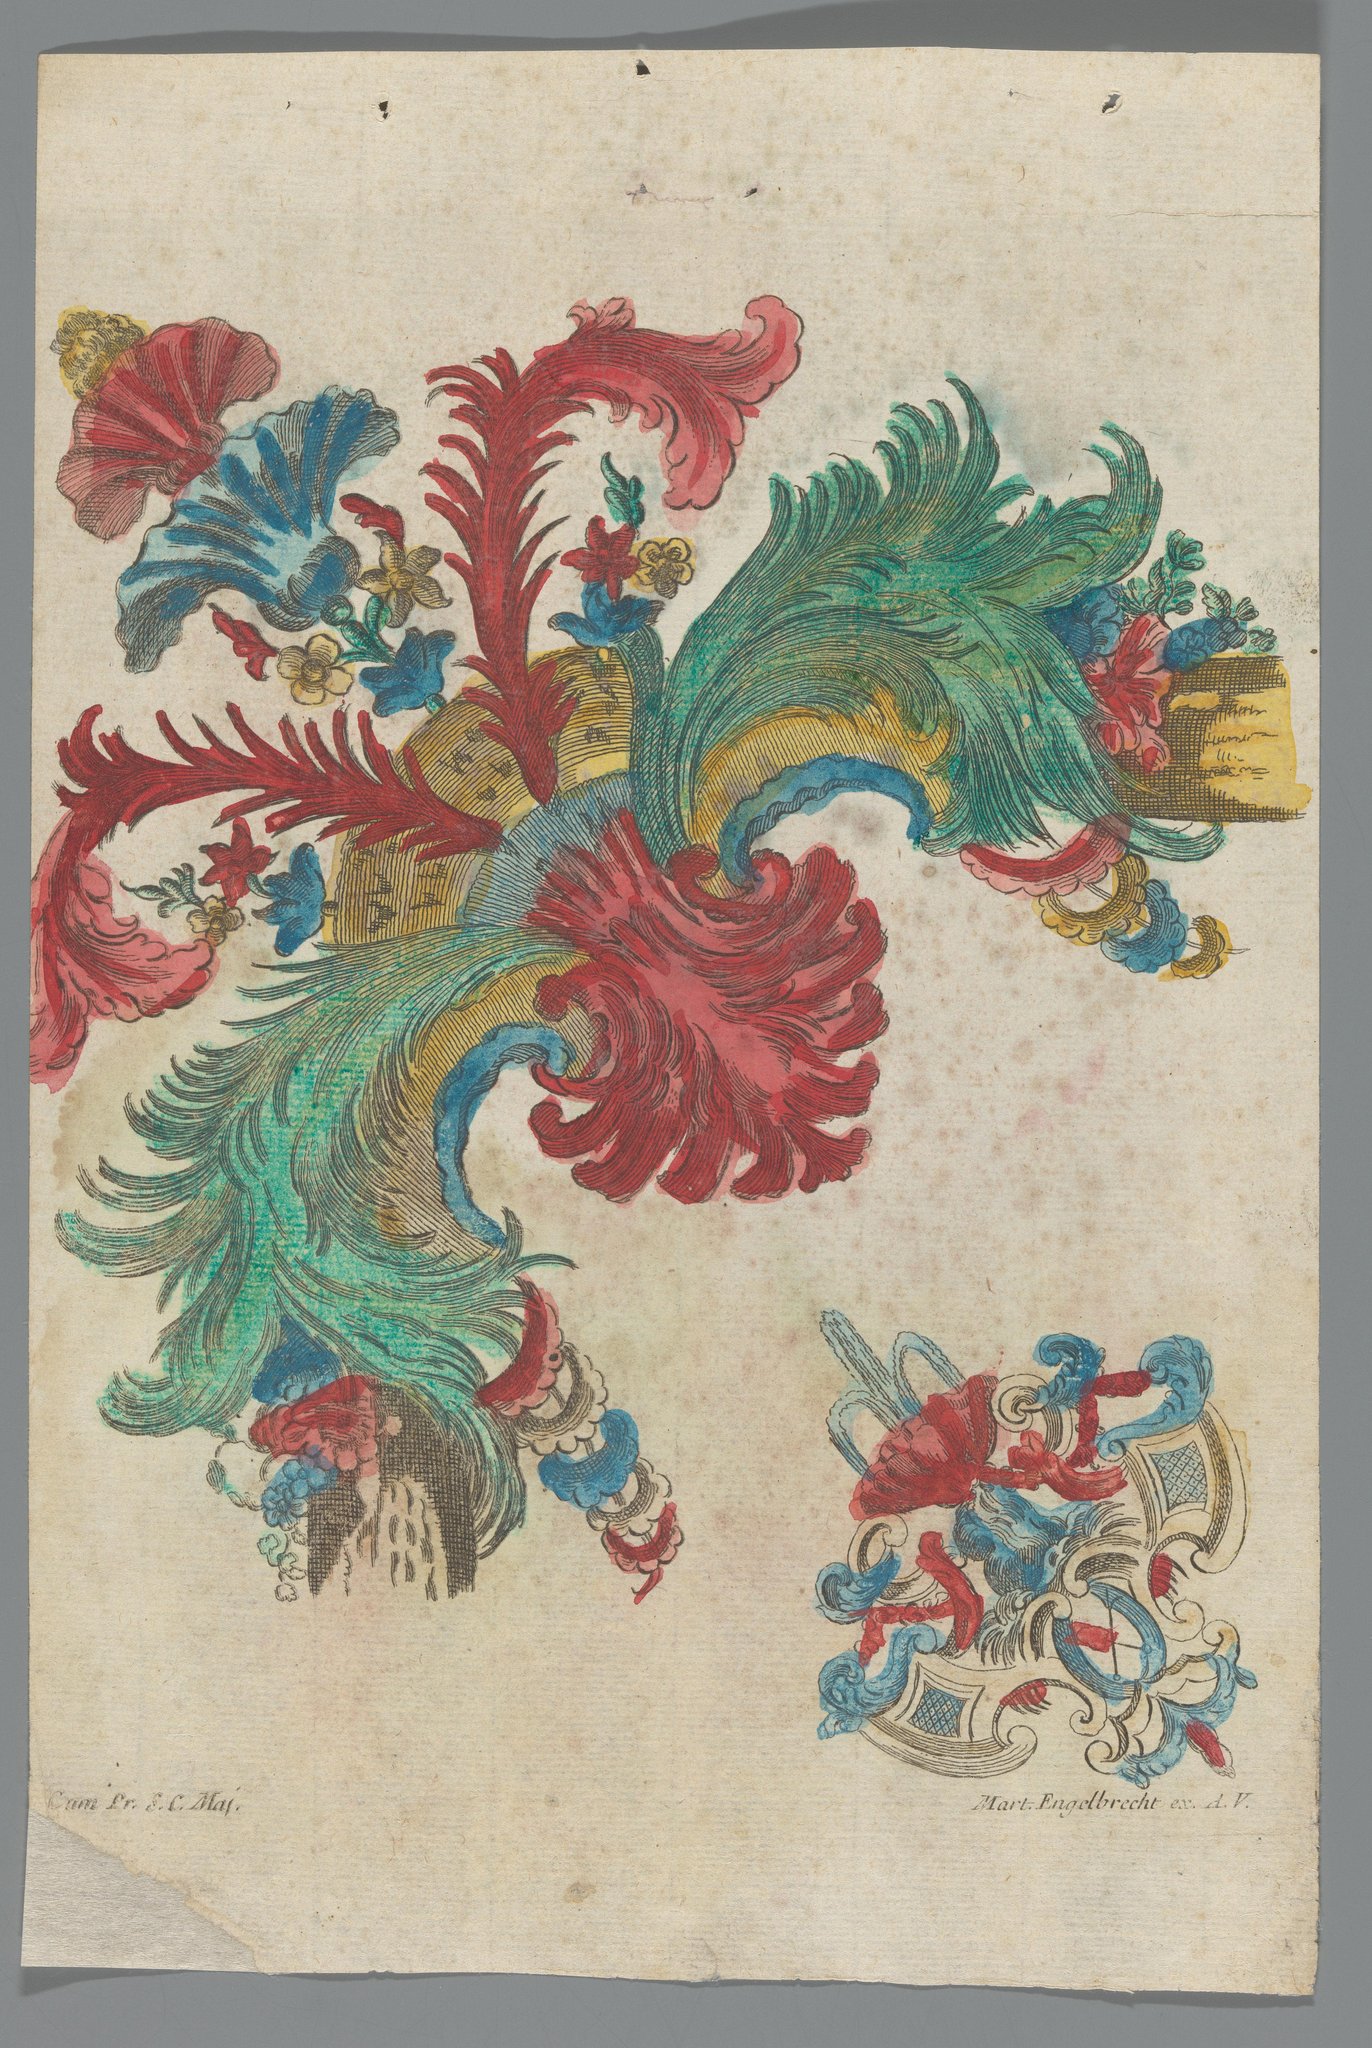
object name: print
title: Bladen met knipplaatjes en decoratieve randen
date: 1698-1756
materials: paper, watercolor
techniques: etching, hand coloring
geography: augsburg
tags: foliage, tendrils, branches ~ ornament, flowers ~ ornament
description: Twee ornamenten met bloemen en pluimen. Een van 39 bladen met knipplaatjes en decoratieve randen